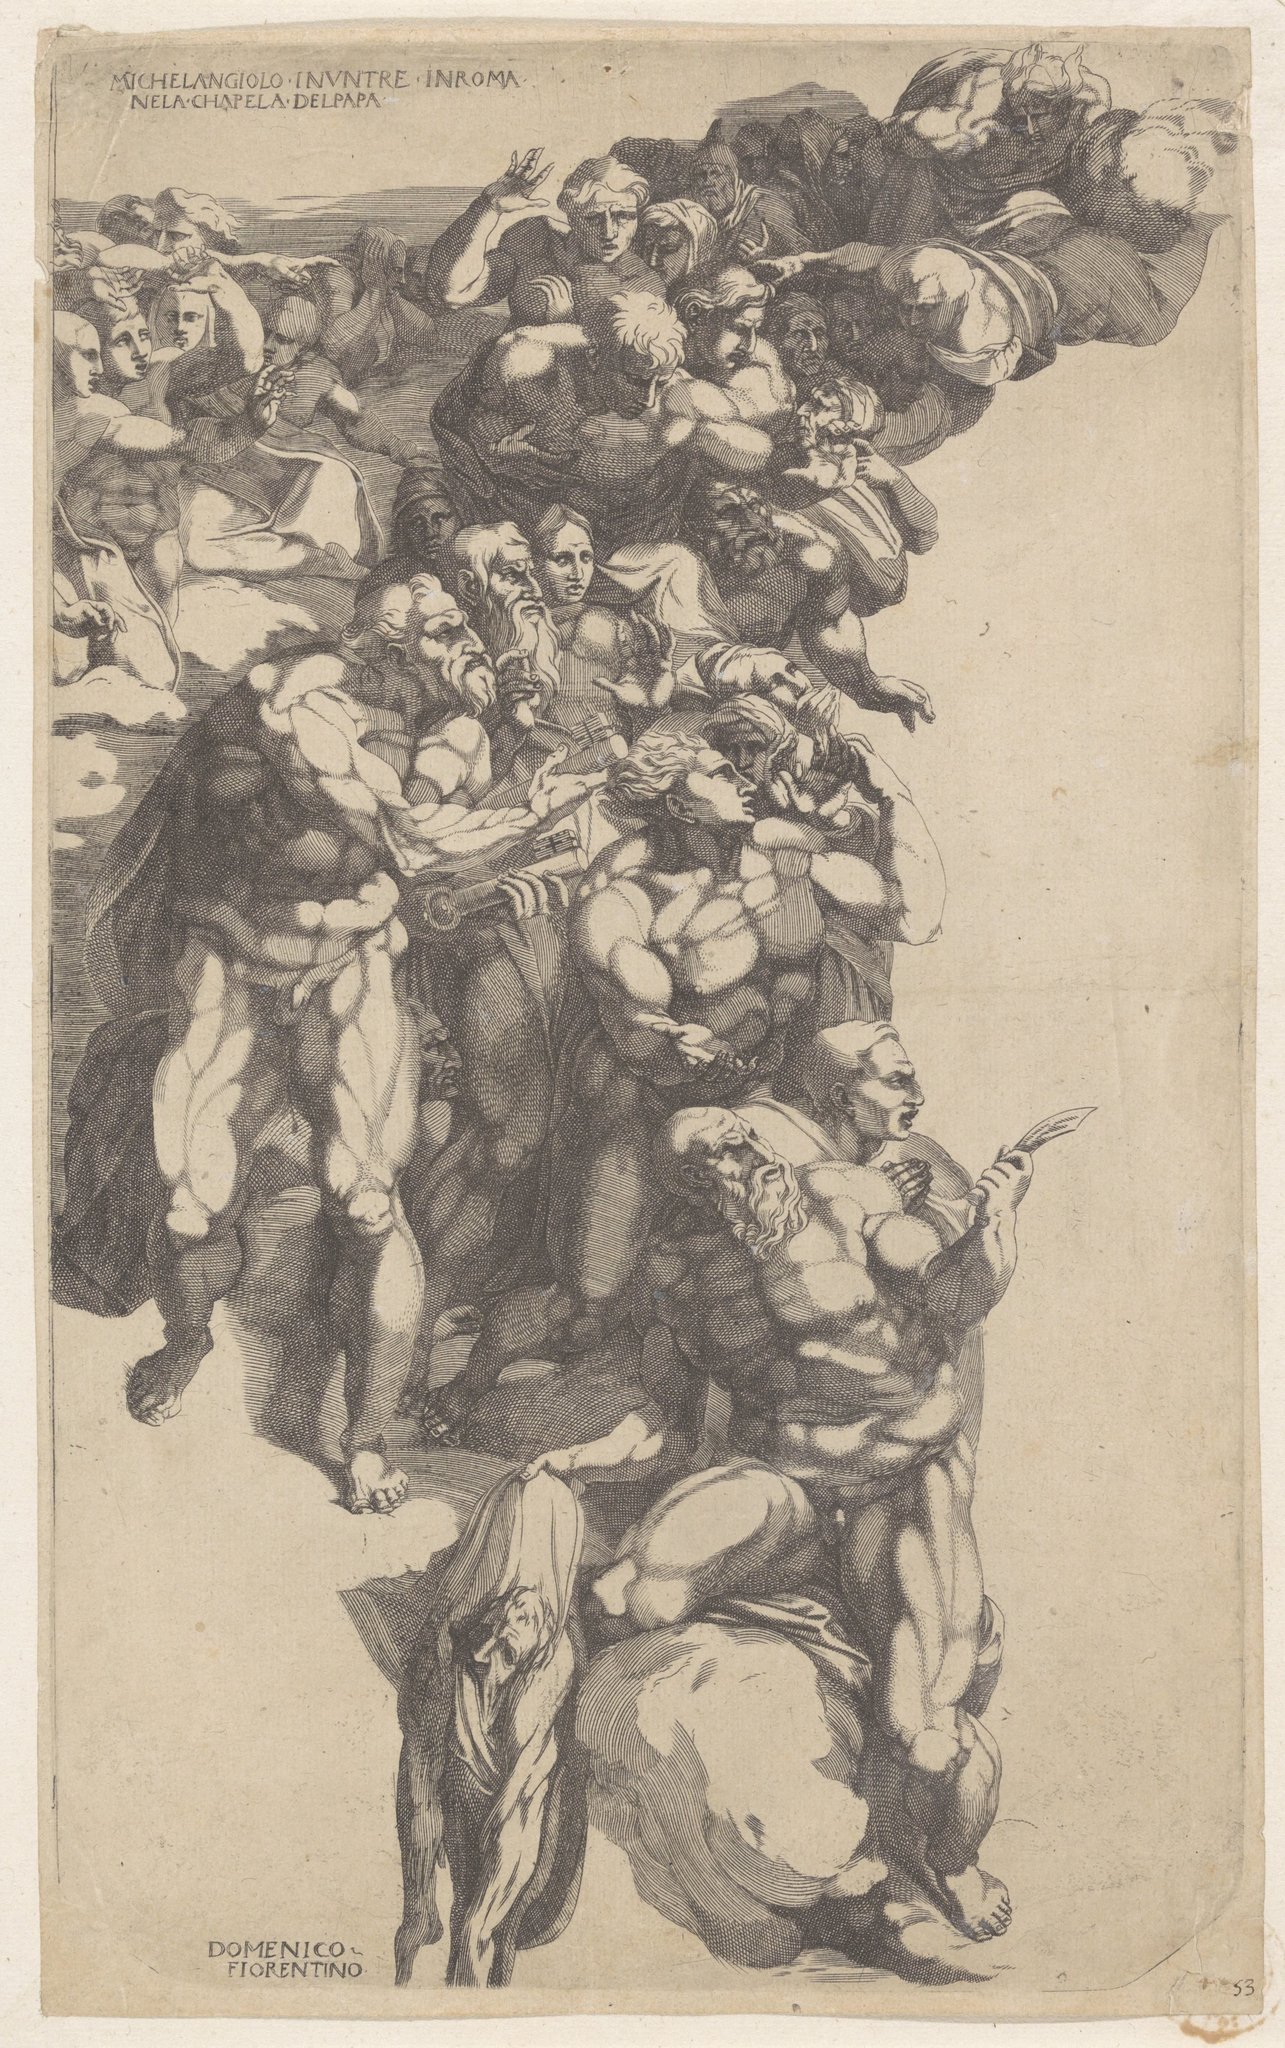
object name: print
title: Groep heiligen uit Michelangelo's Laatste Oordeel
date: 1541-1565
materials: paper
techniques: engraving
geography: florence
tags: last judgement, saints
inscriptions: number: ‘53’, collector's mark: Lugt 240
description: Een groep heiligen uit Michelangelo's Laatste Oordeel. Midden voor Bartolomeüs met in zijn handen een mes en zijn gestroopte huid. Links Petrus met sleutels.